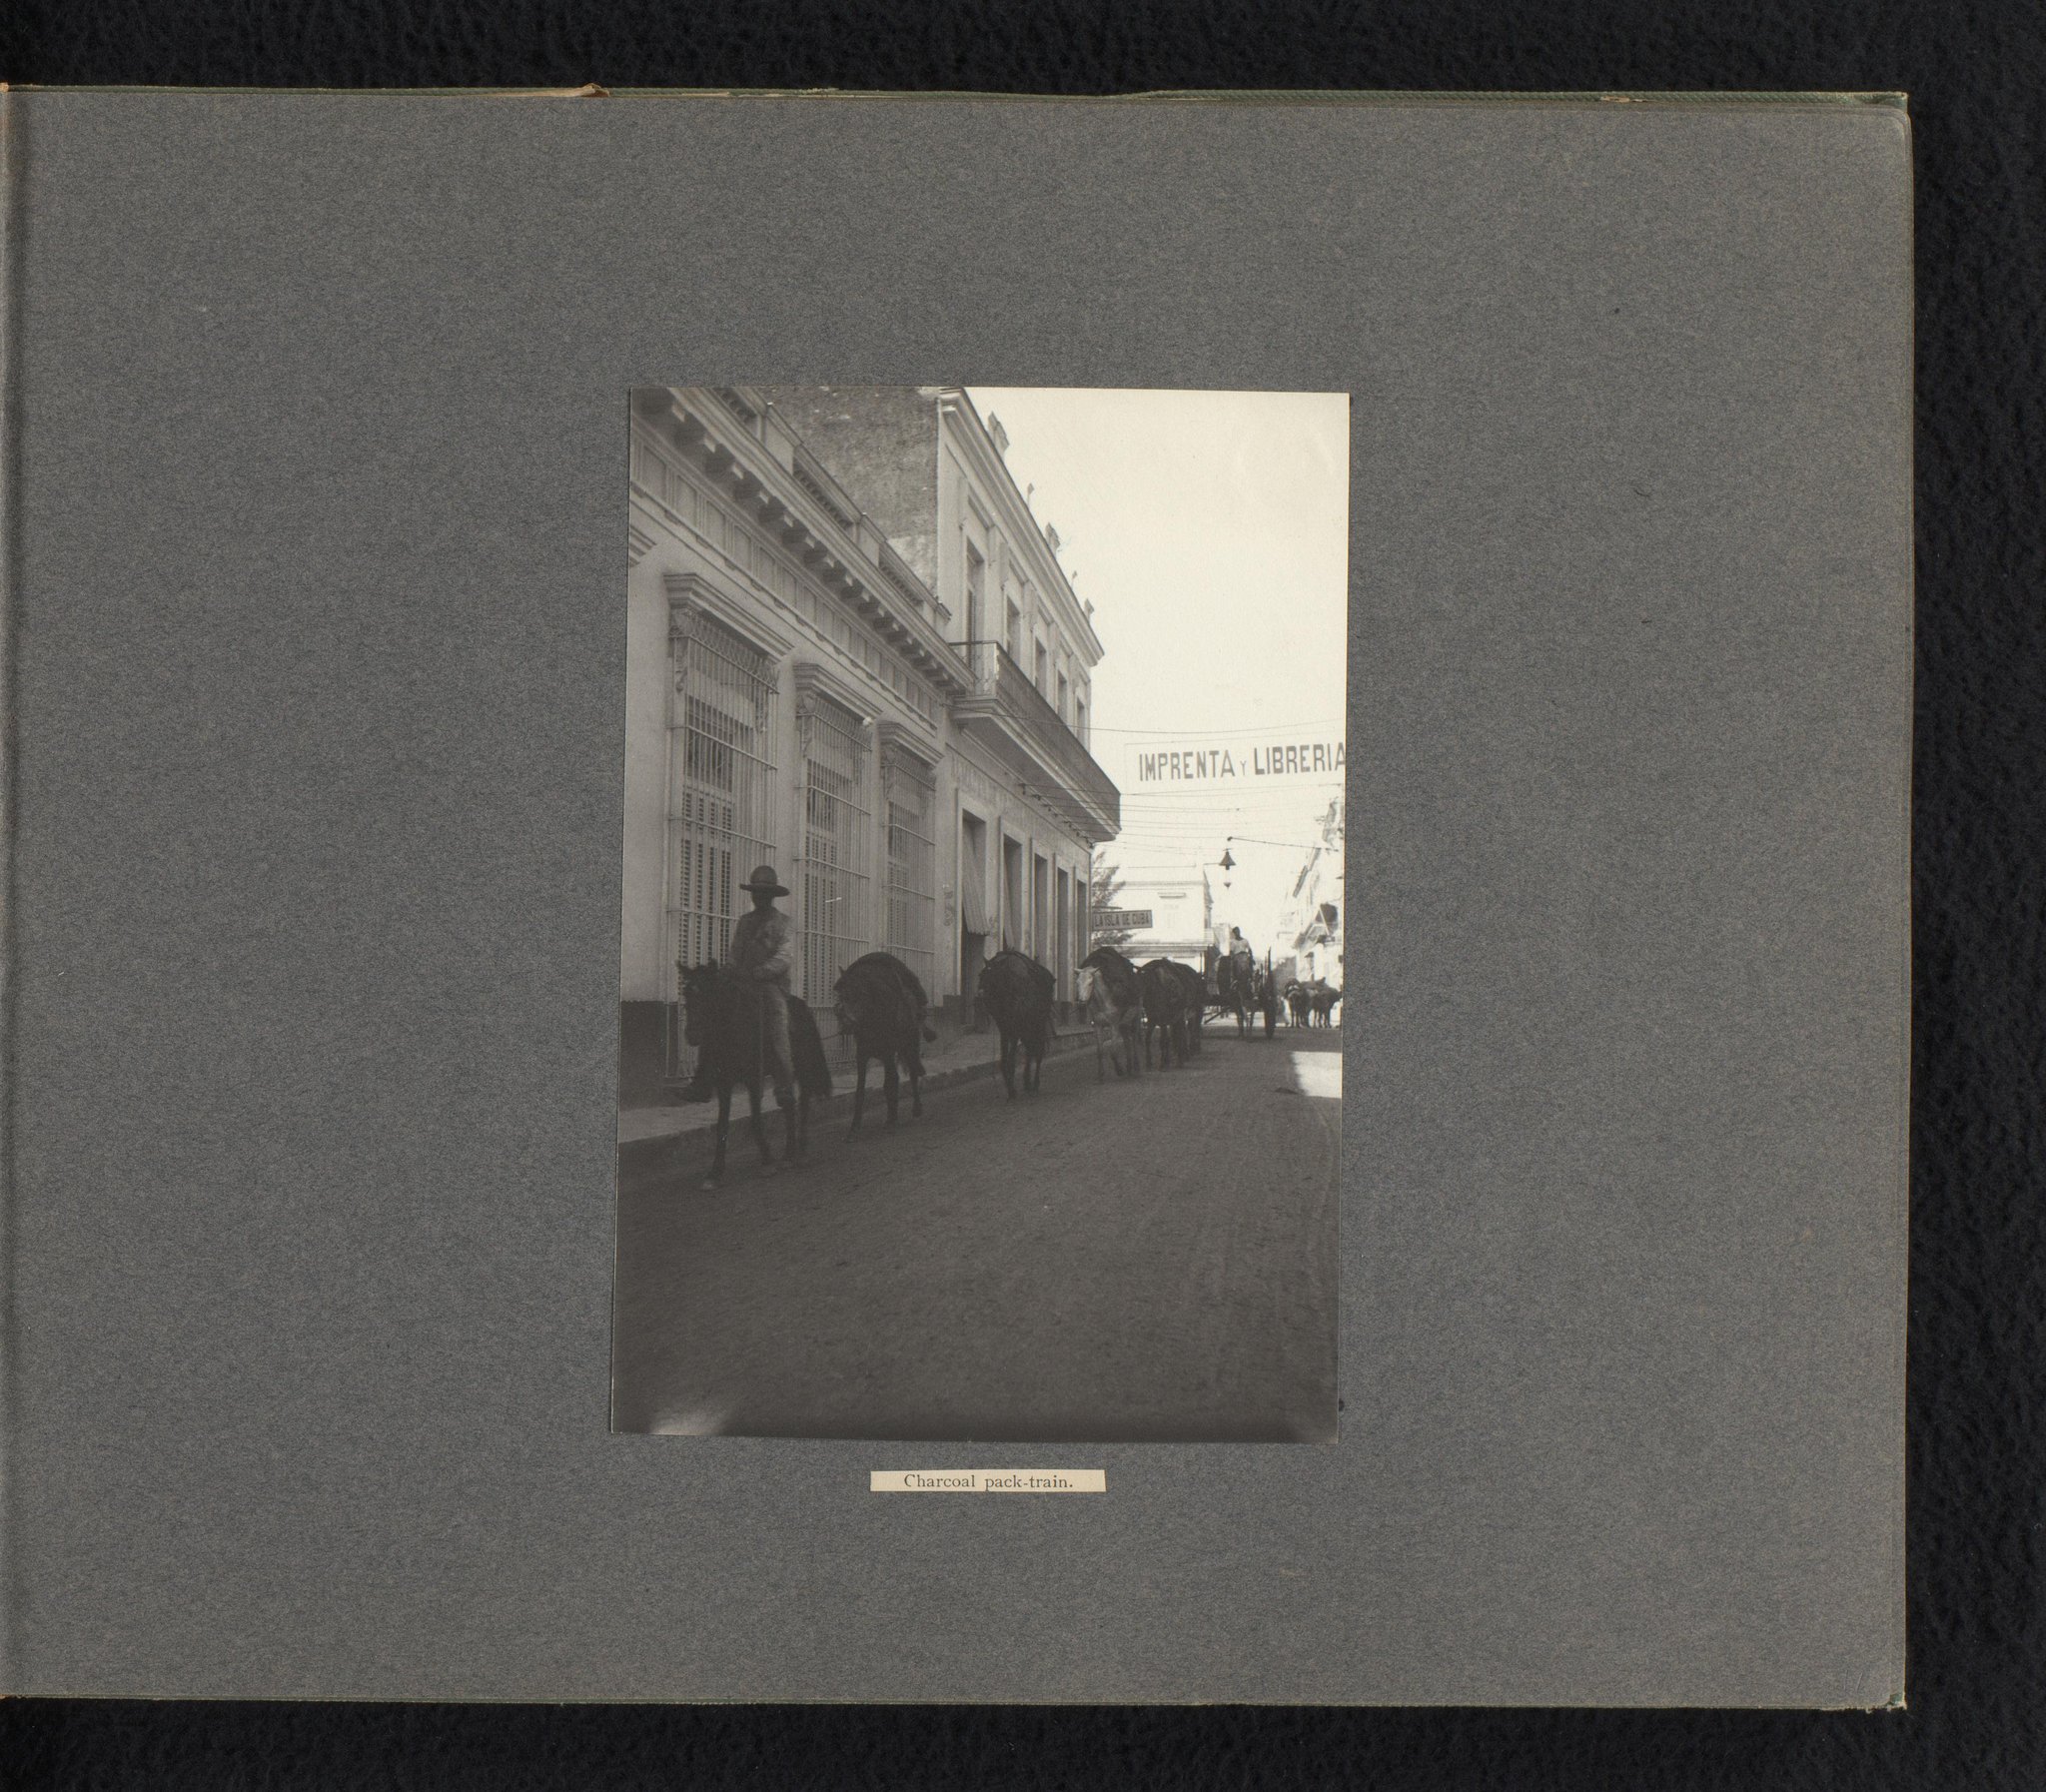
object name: photograph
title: Karavaan met paarden beladen met houtskool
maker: Anonymous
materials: paper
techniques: platinum process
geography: cuba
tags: pack-animal